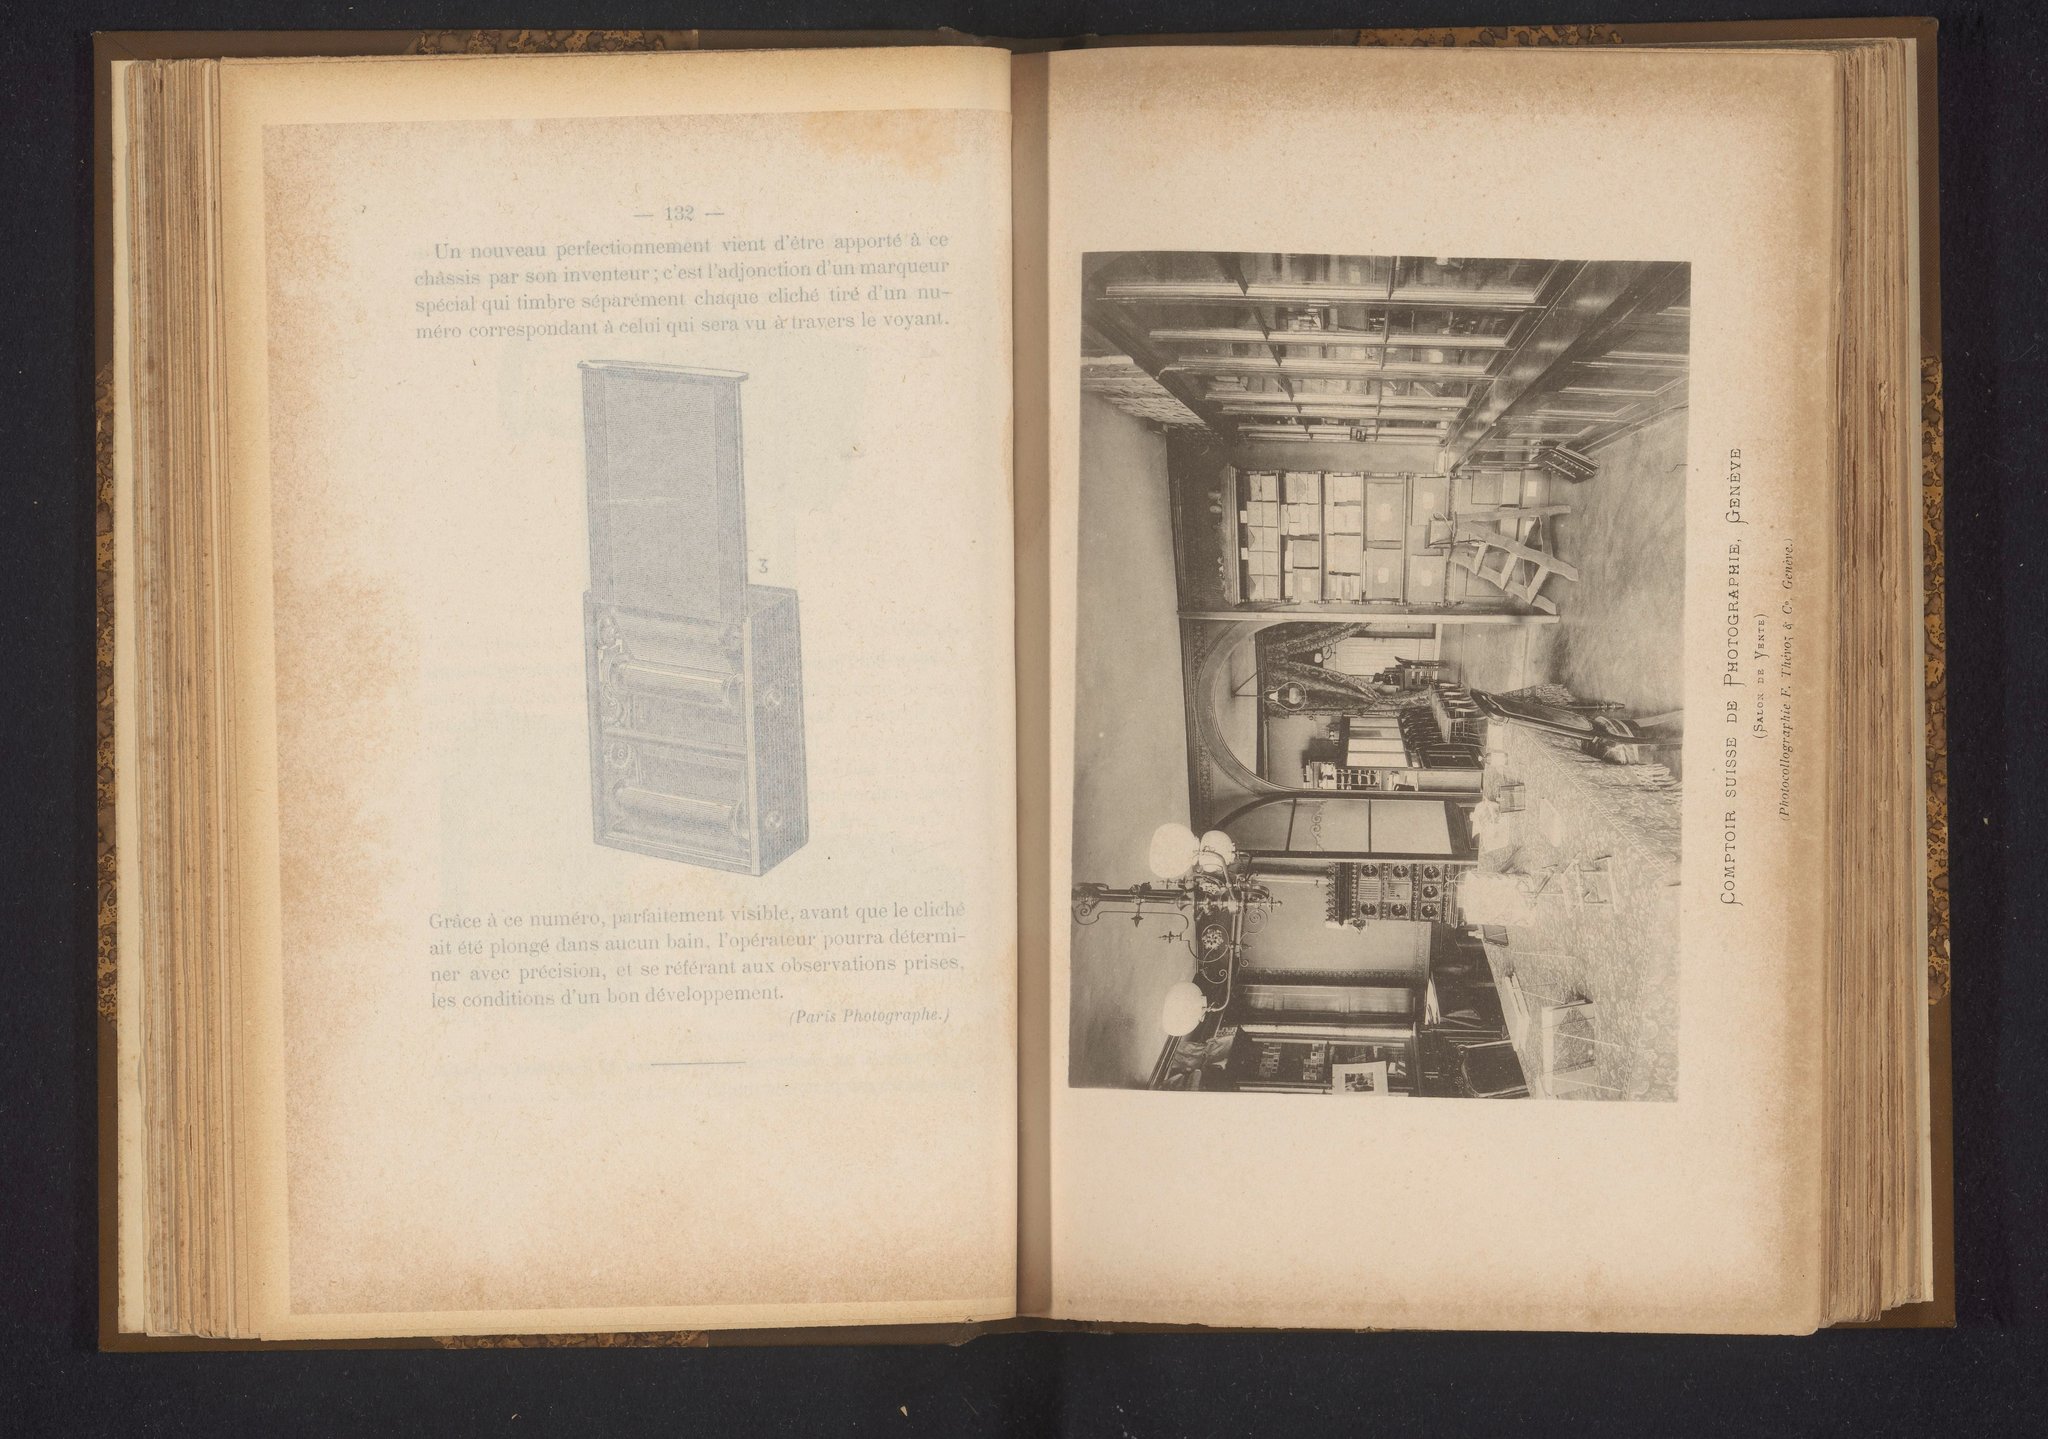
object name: page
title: Interieur van een Zwitserse fotografiewinkel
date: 1888-1893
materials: paper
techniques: photograph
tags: edifice, e.g.: public building, department store - aa - civic architecture: inside, lighting; lamps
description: Prent op tweede en derde pagina na pagina 131.